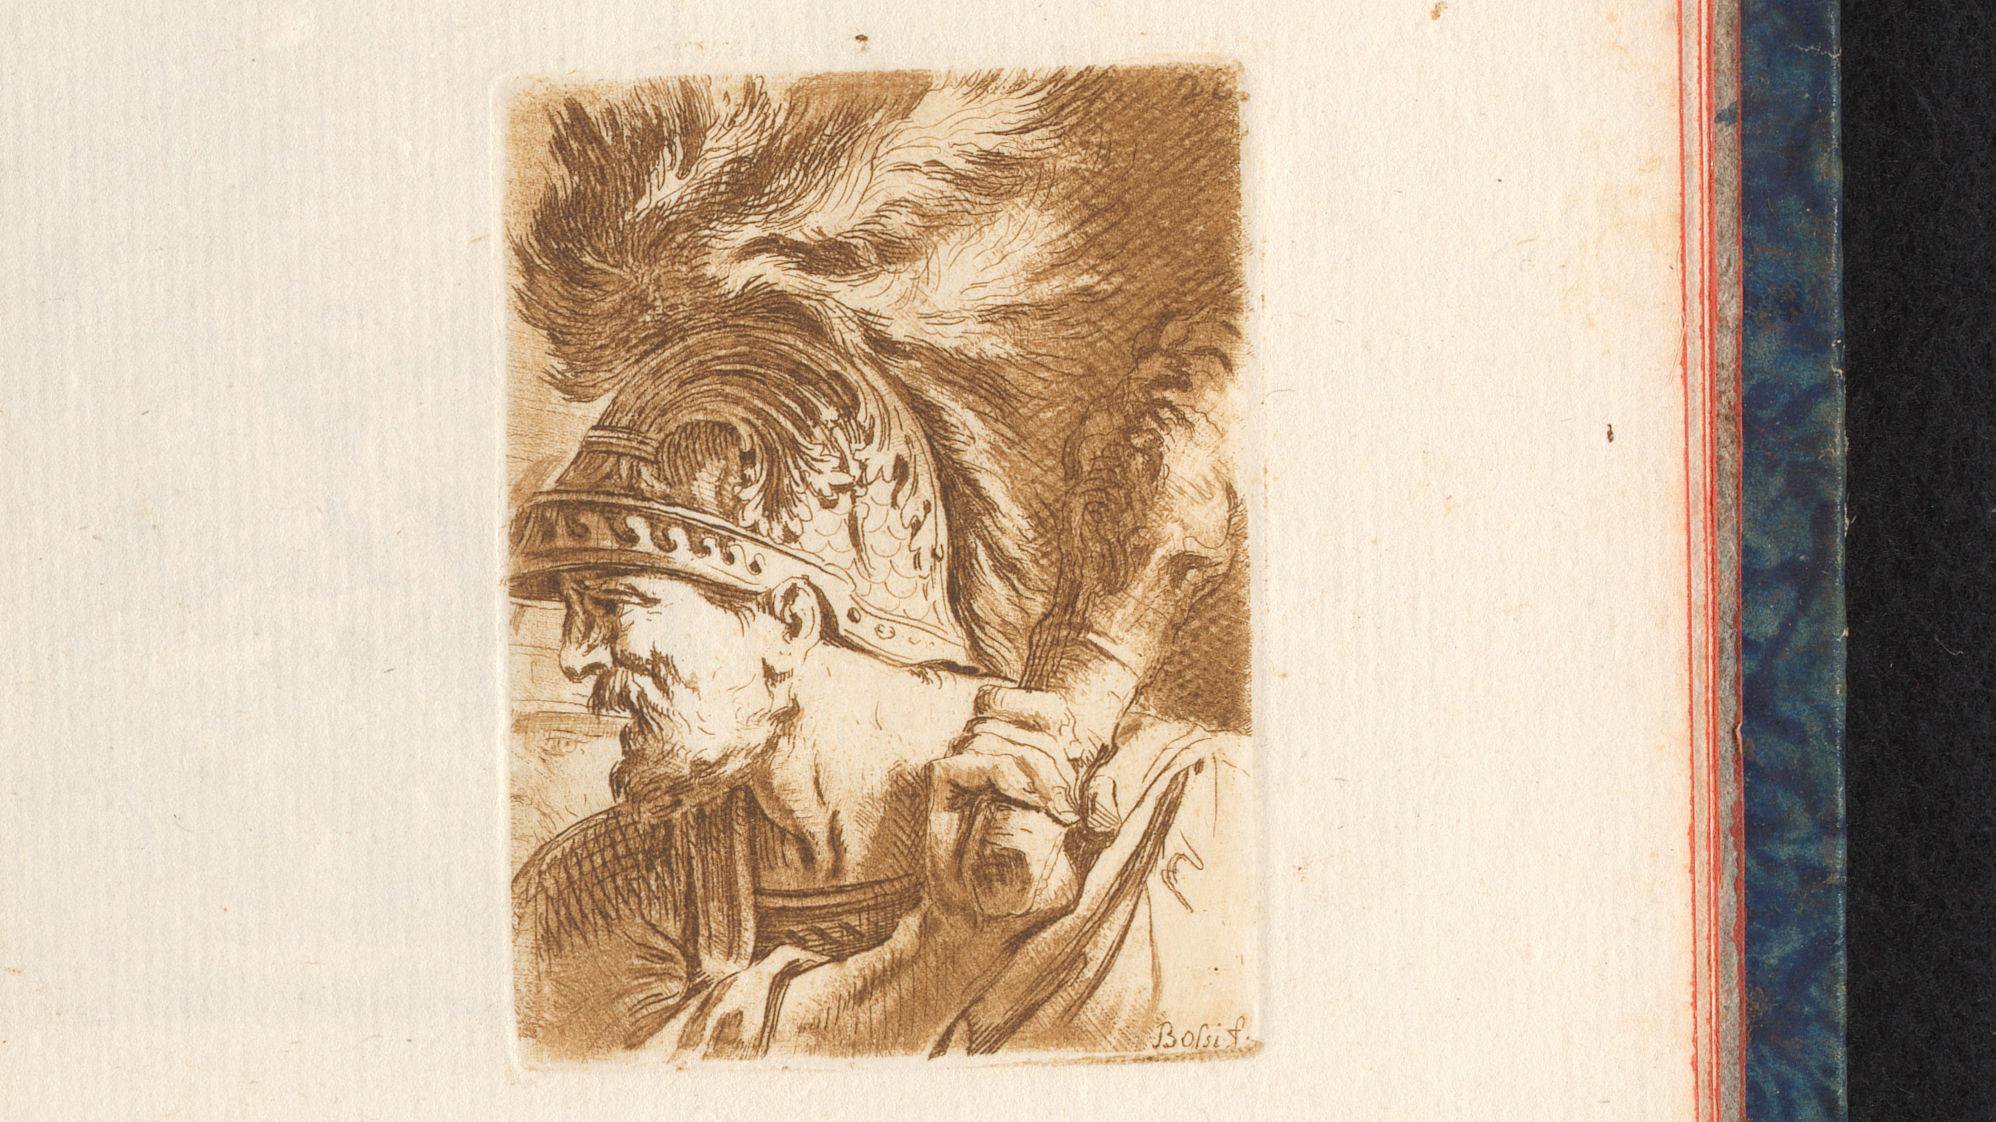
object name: print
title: Raccolta di teste, pensieri, trofei e prove varie d'acquaforte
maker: benigno bossi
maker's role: print maker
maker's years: 1727-1792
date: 1754-1772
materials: paper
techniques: aquatint, etching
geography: parma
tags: (story of) prometheus